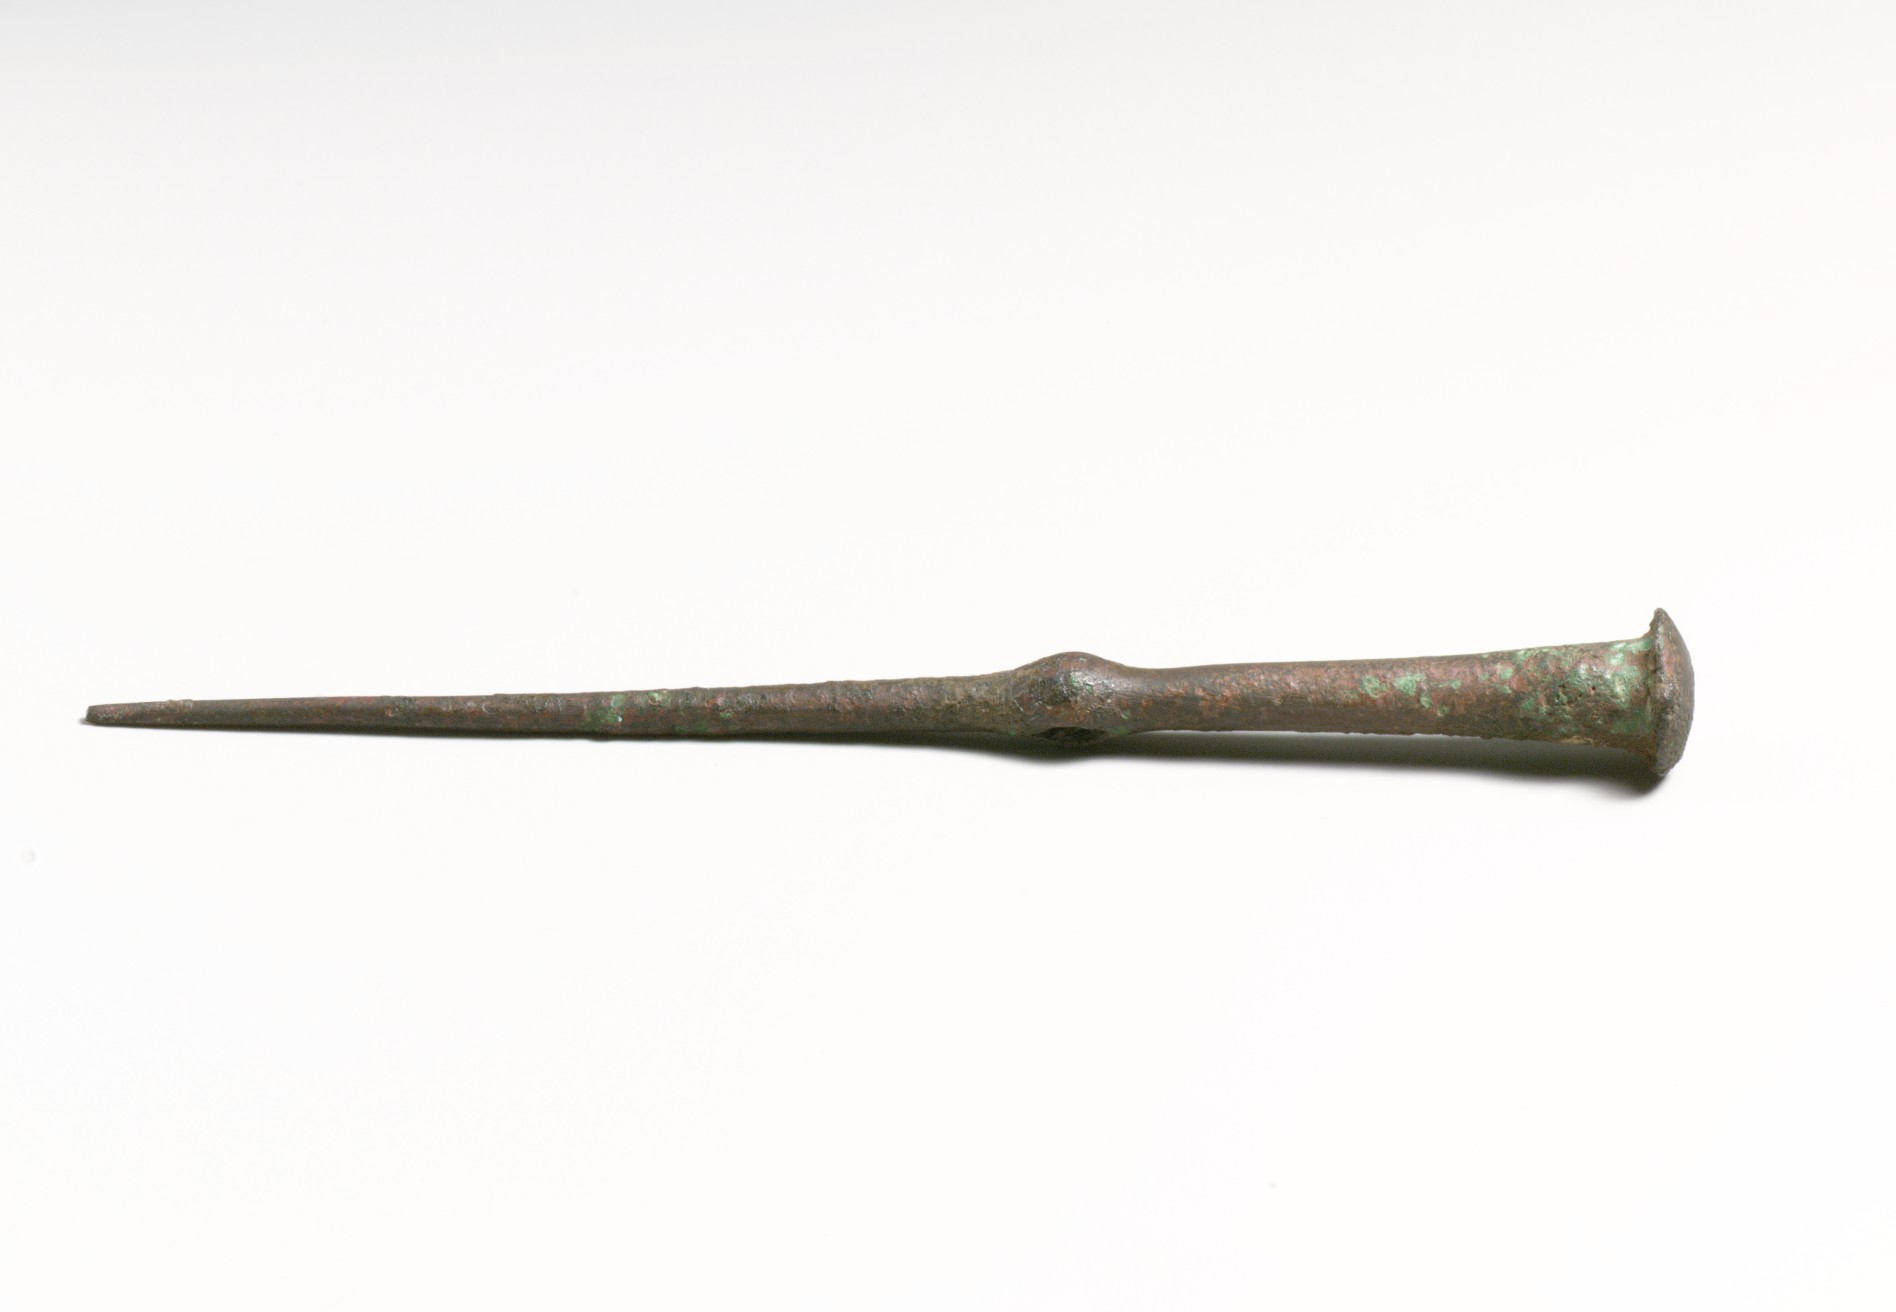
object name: pin, eyelet type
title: Bronze toggle pin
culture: cypriot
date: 1900-1600 BCE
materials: bronze